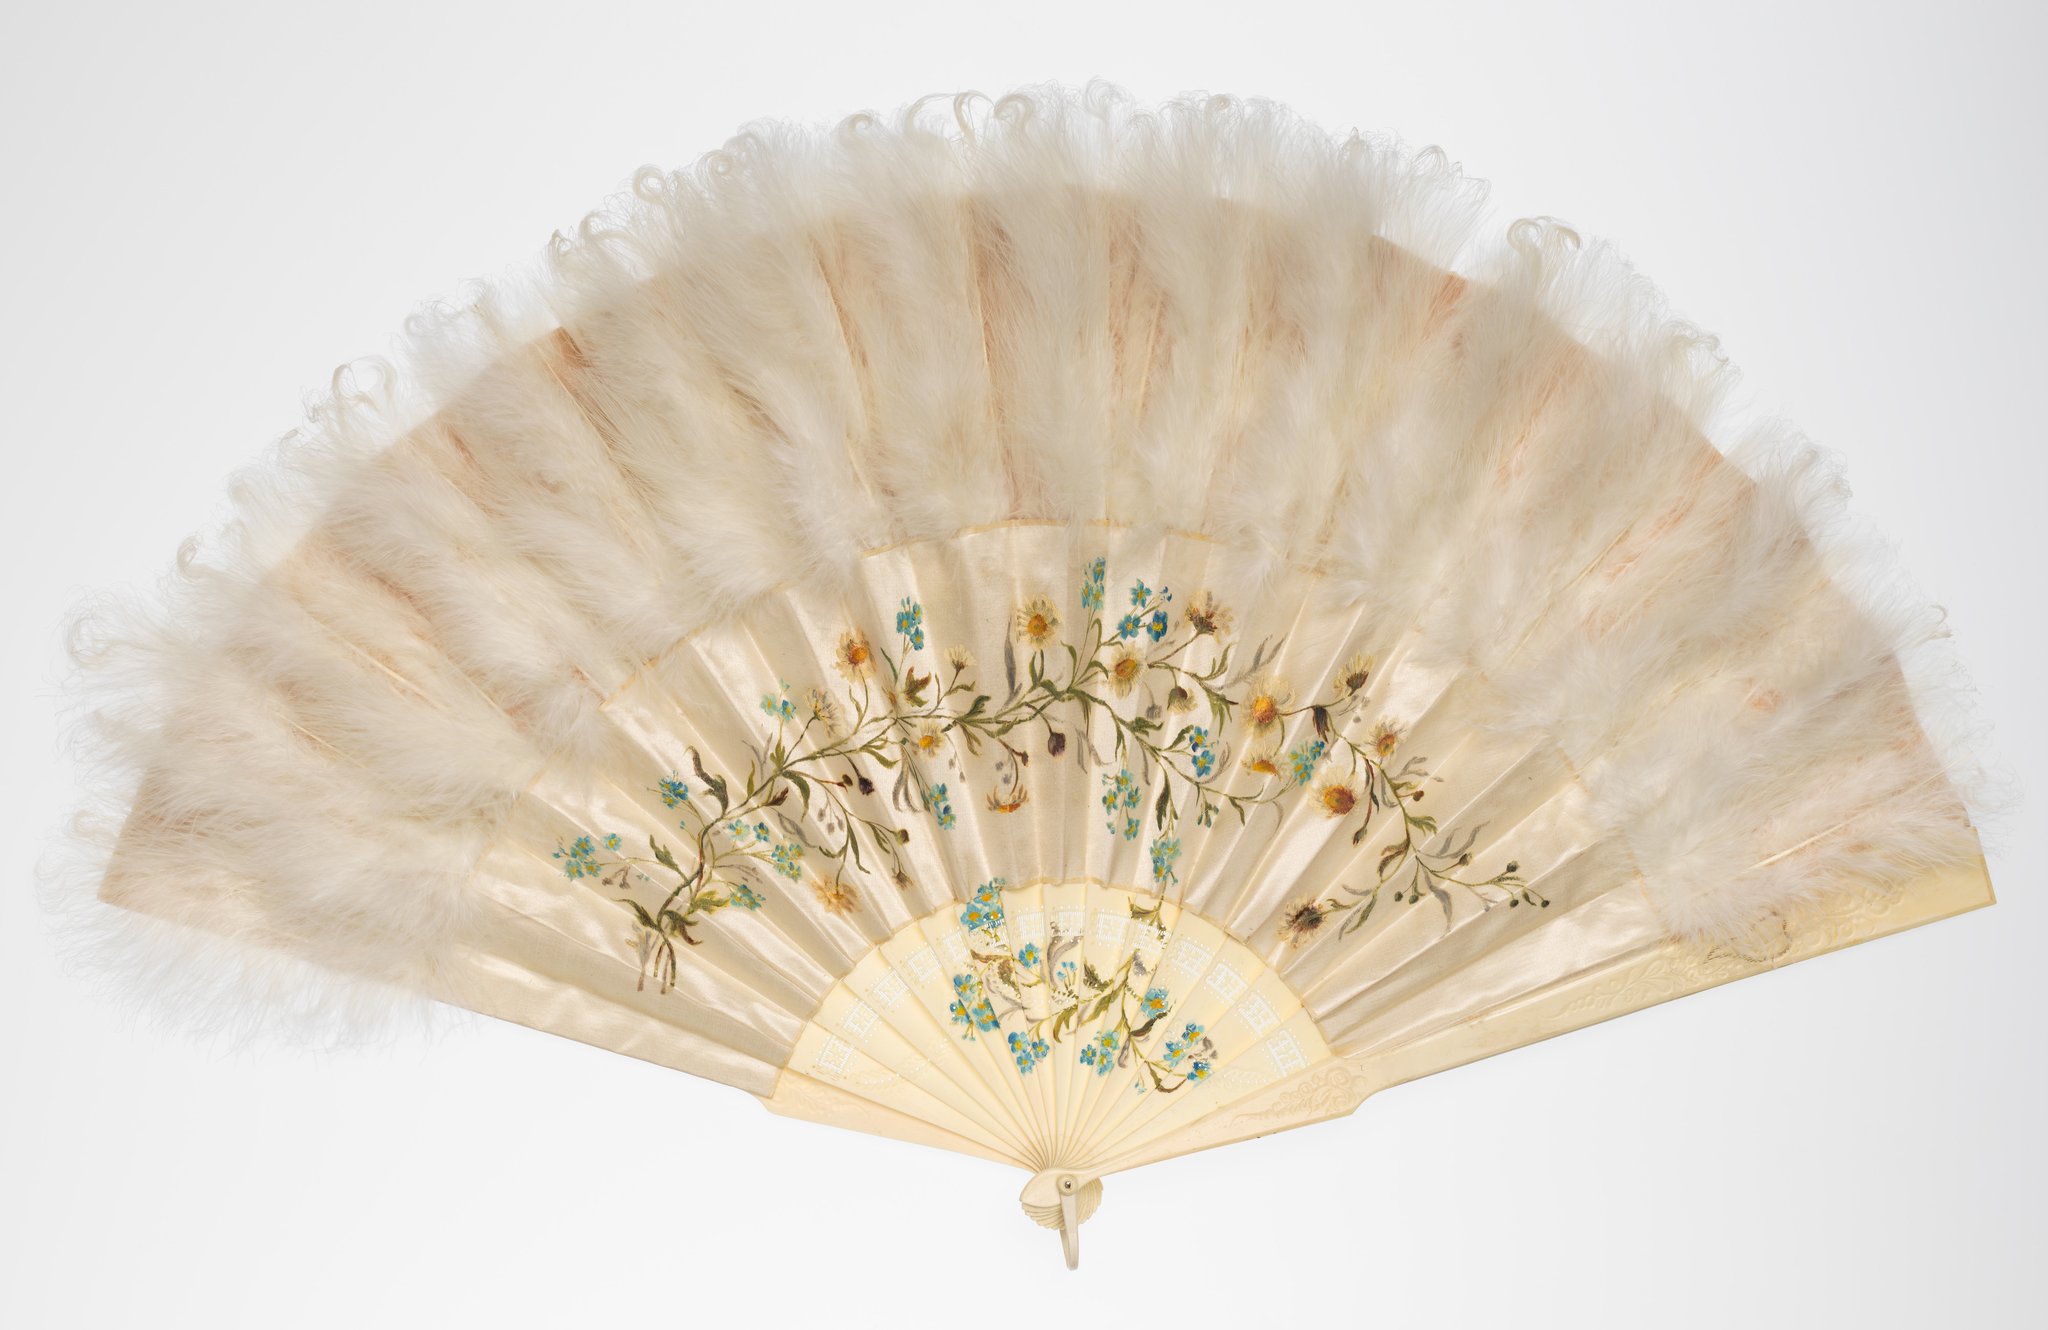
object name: fan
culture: american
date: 1890-1894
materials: feather, silk